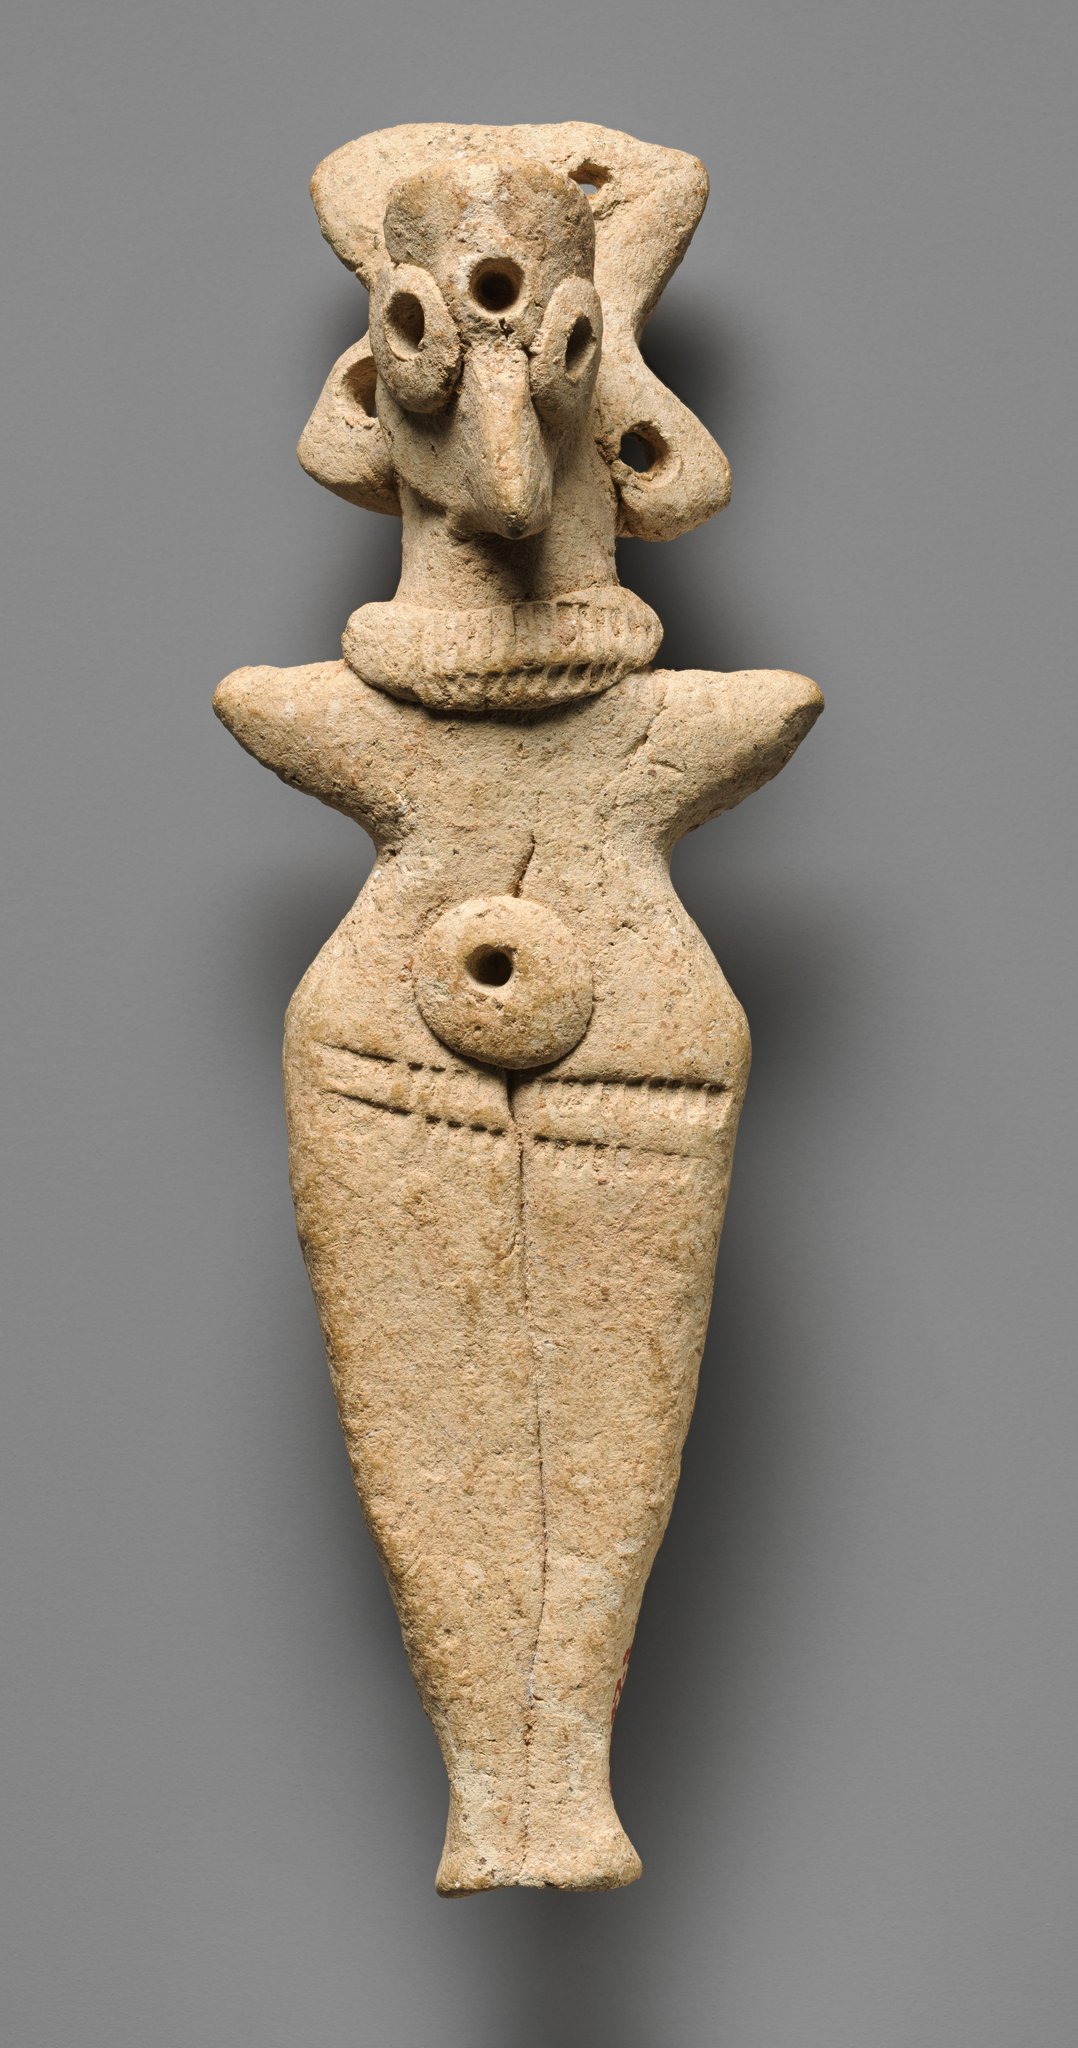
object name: sculpture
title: Nude female figure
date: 2000-1668 BCE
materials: ceramic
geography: levant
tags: female nudes